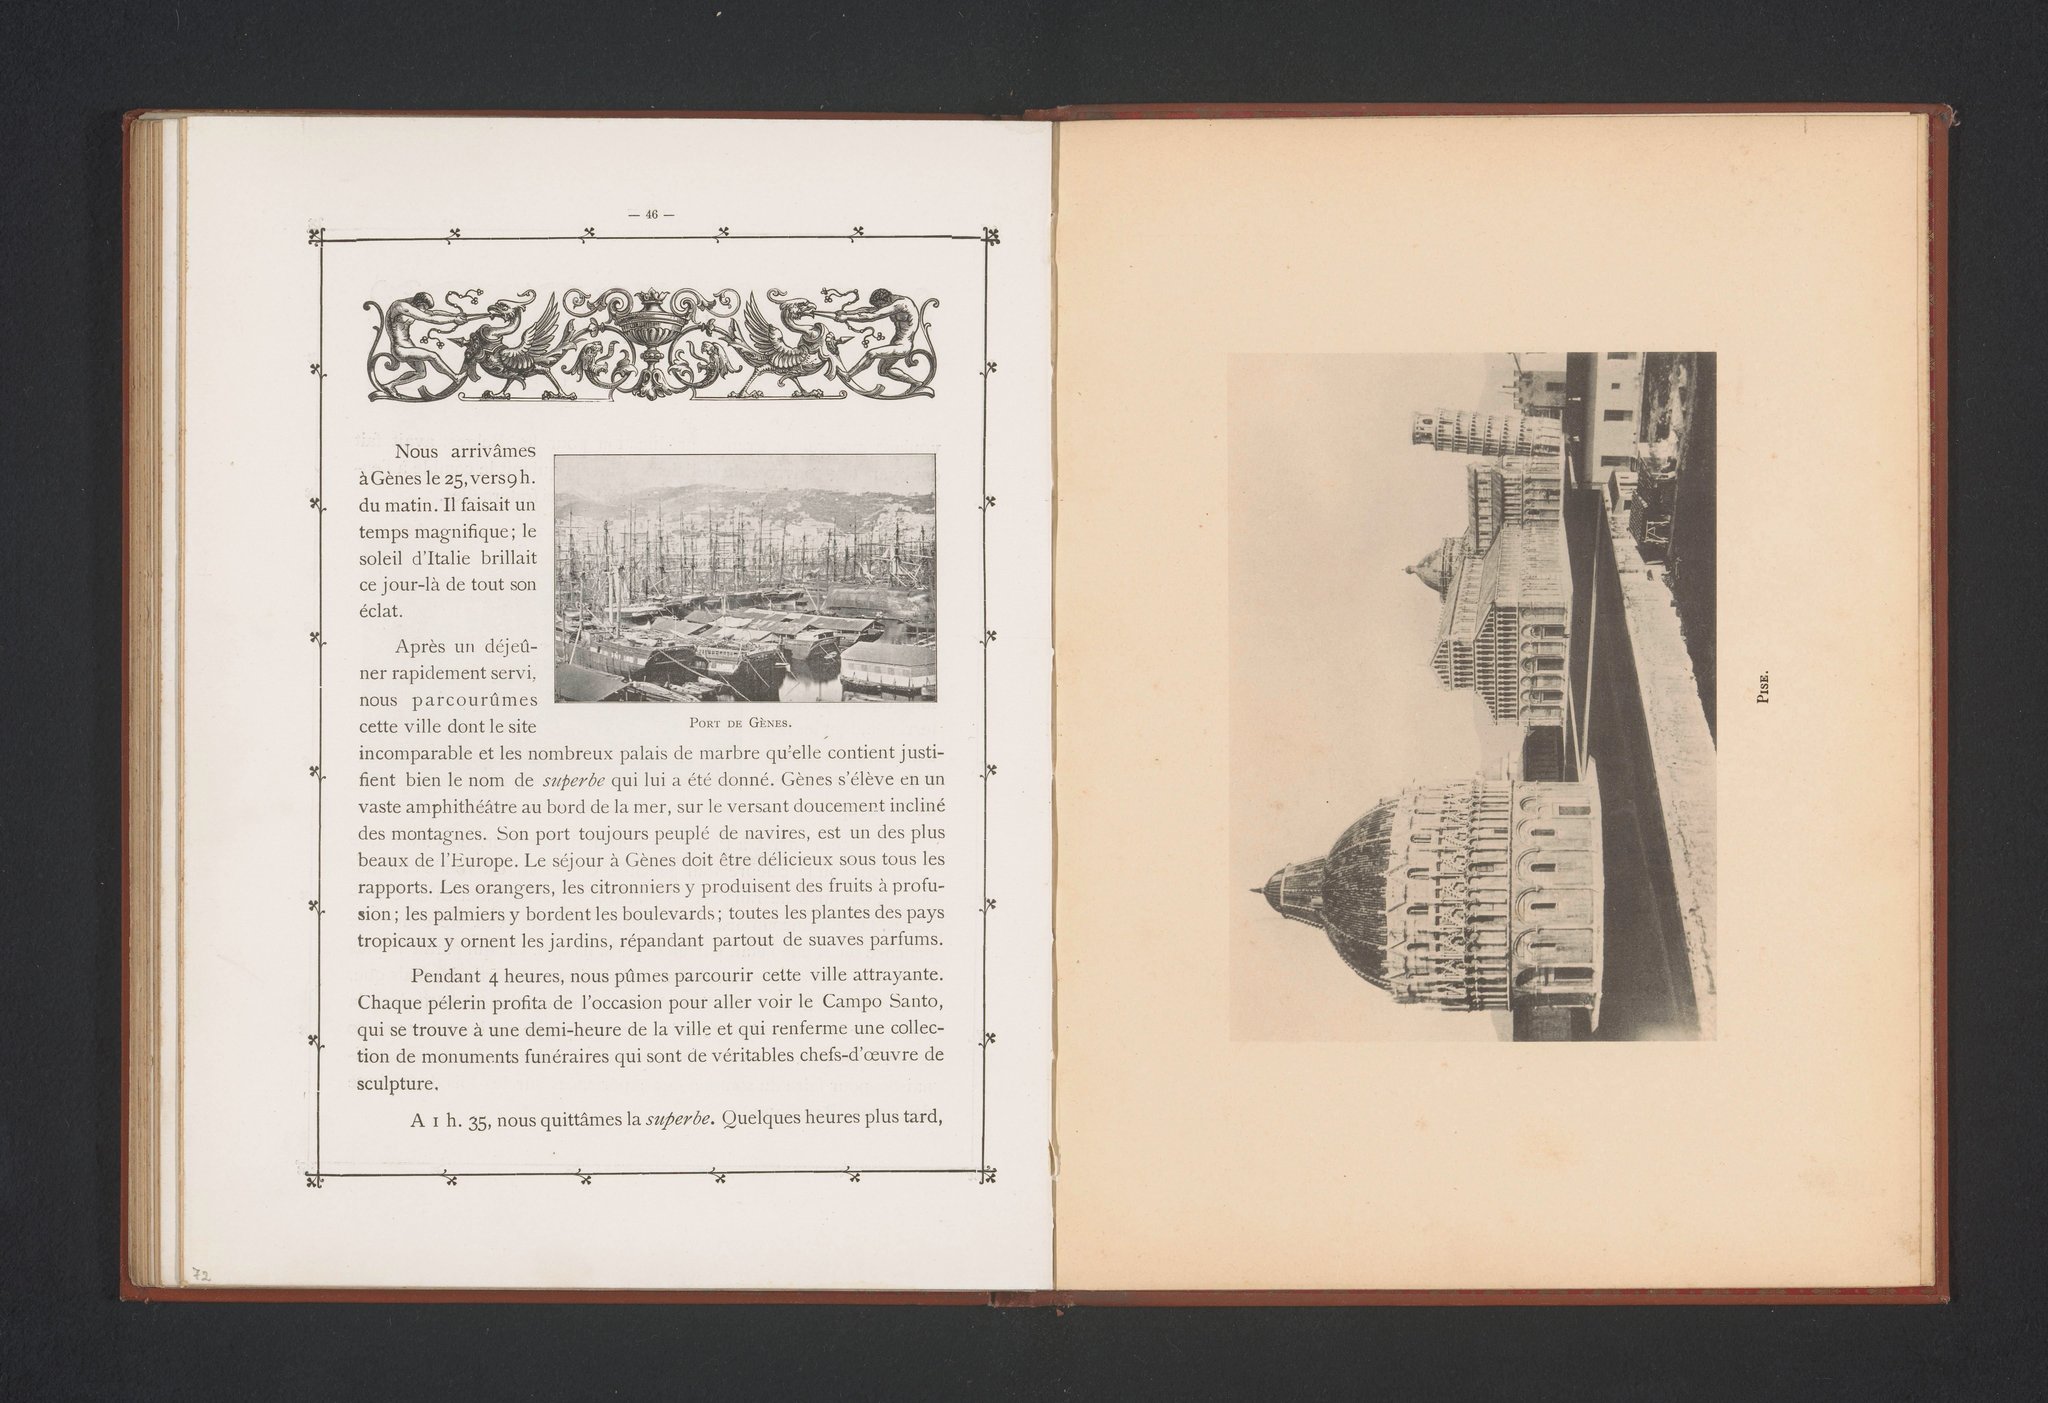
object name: page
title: Gezicht op Pisa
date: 1893-1898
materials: paper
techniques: photograph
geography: pisa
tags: city-view in general; 'veduta'